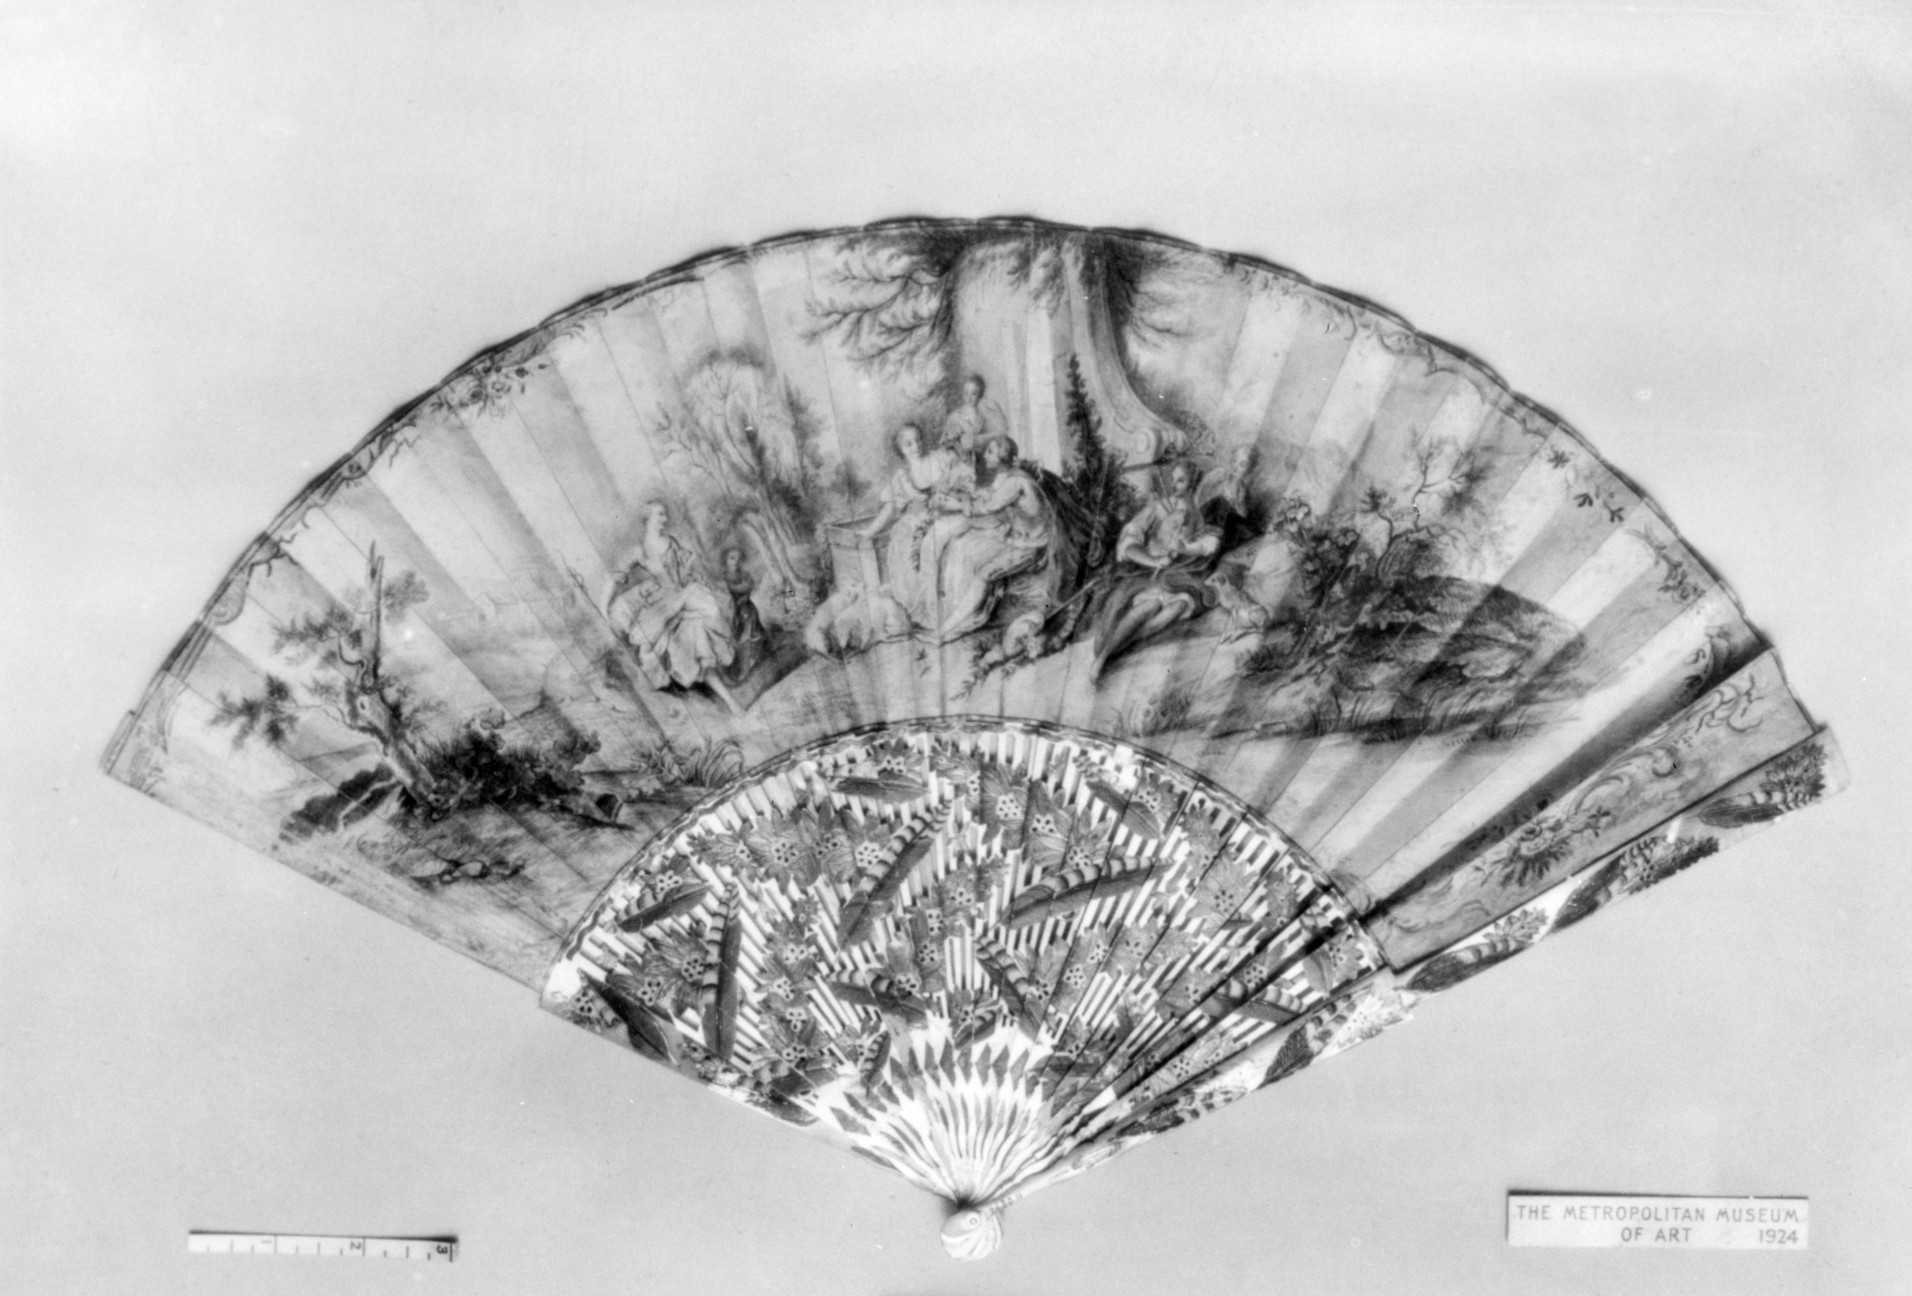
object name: fan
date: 1750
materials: paper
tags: men,women